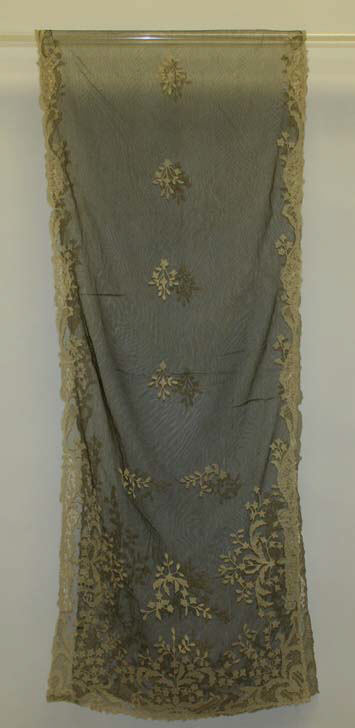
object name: scarf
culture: american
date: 1700-1939